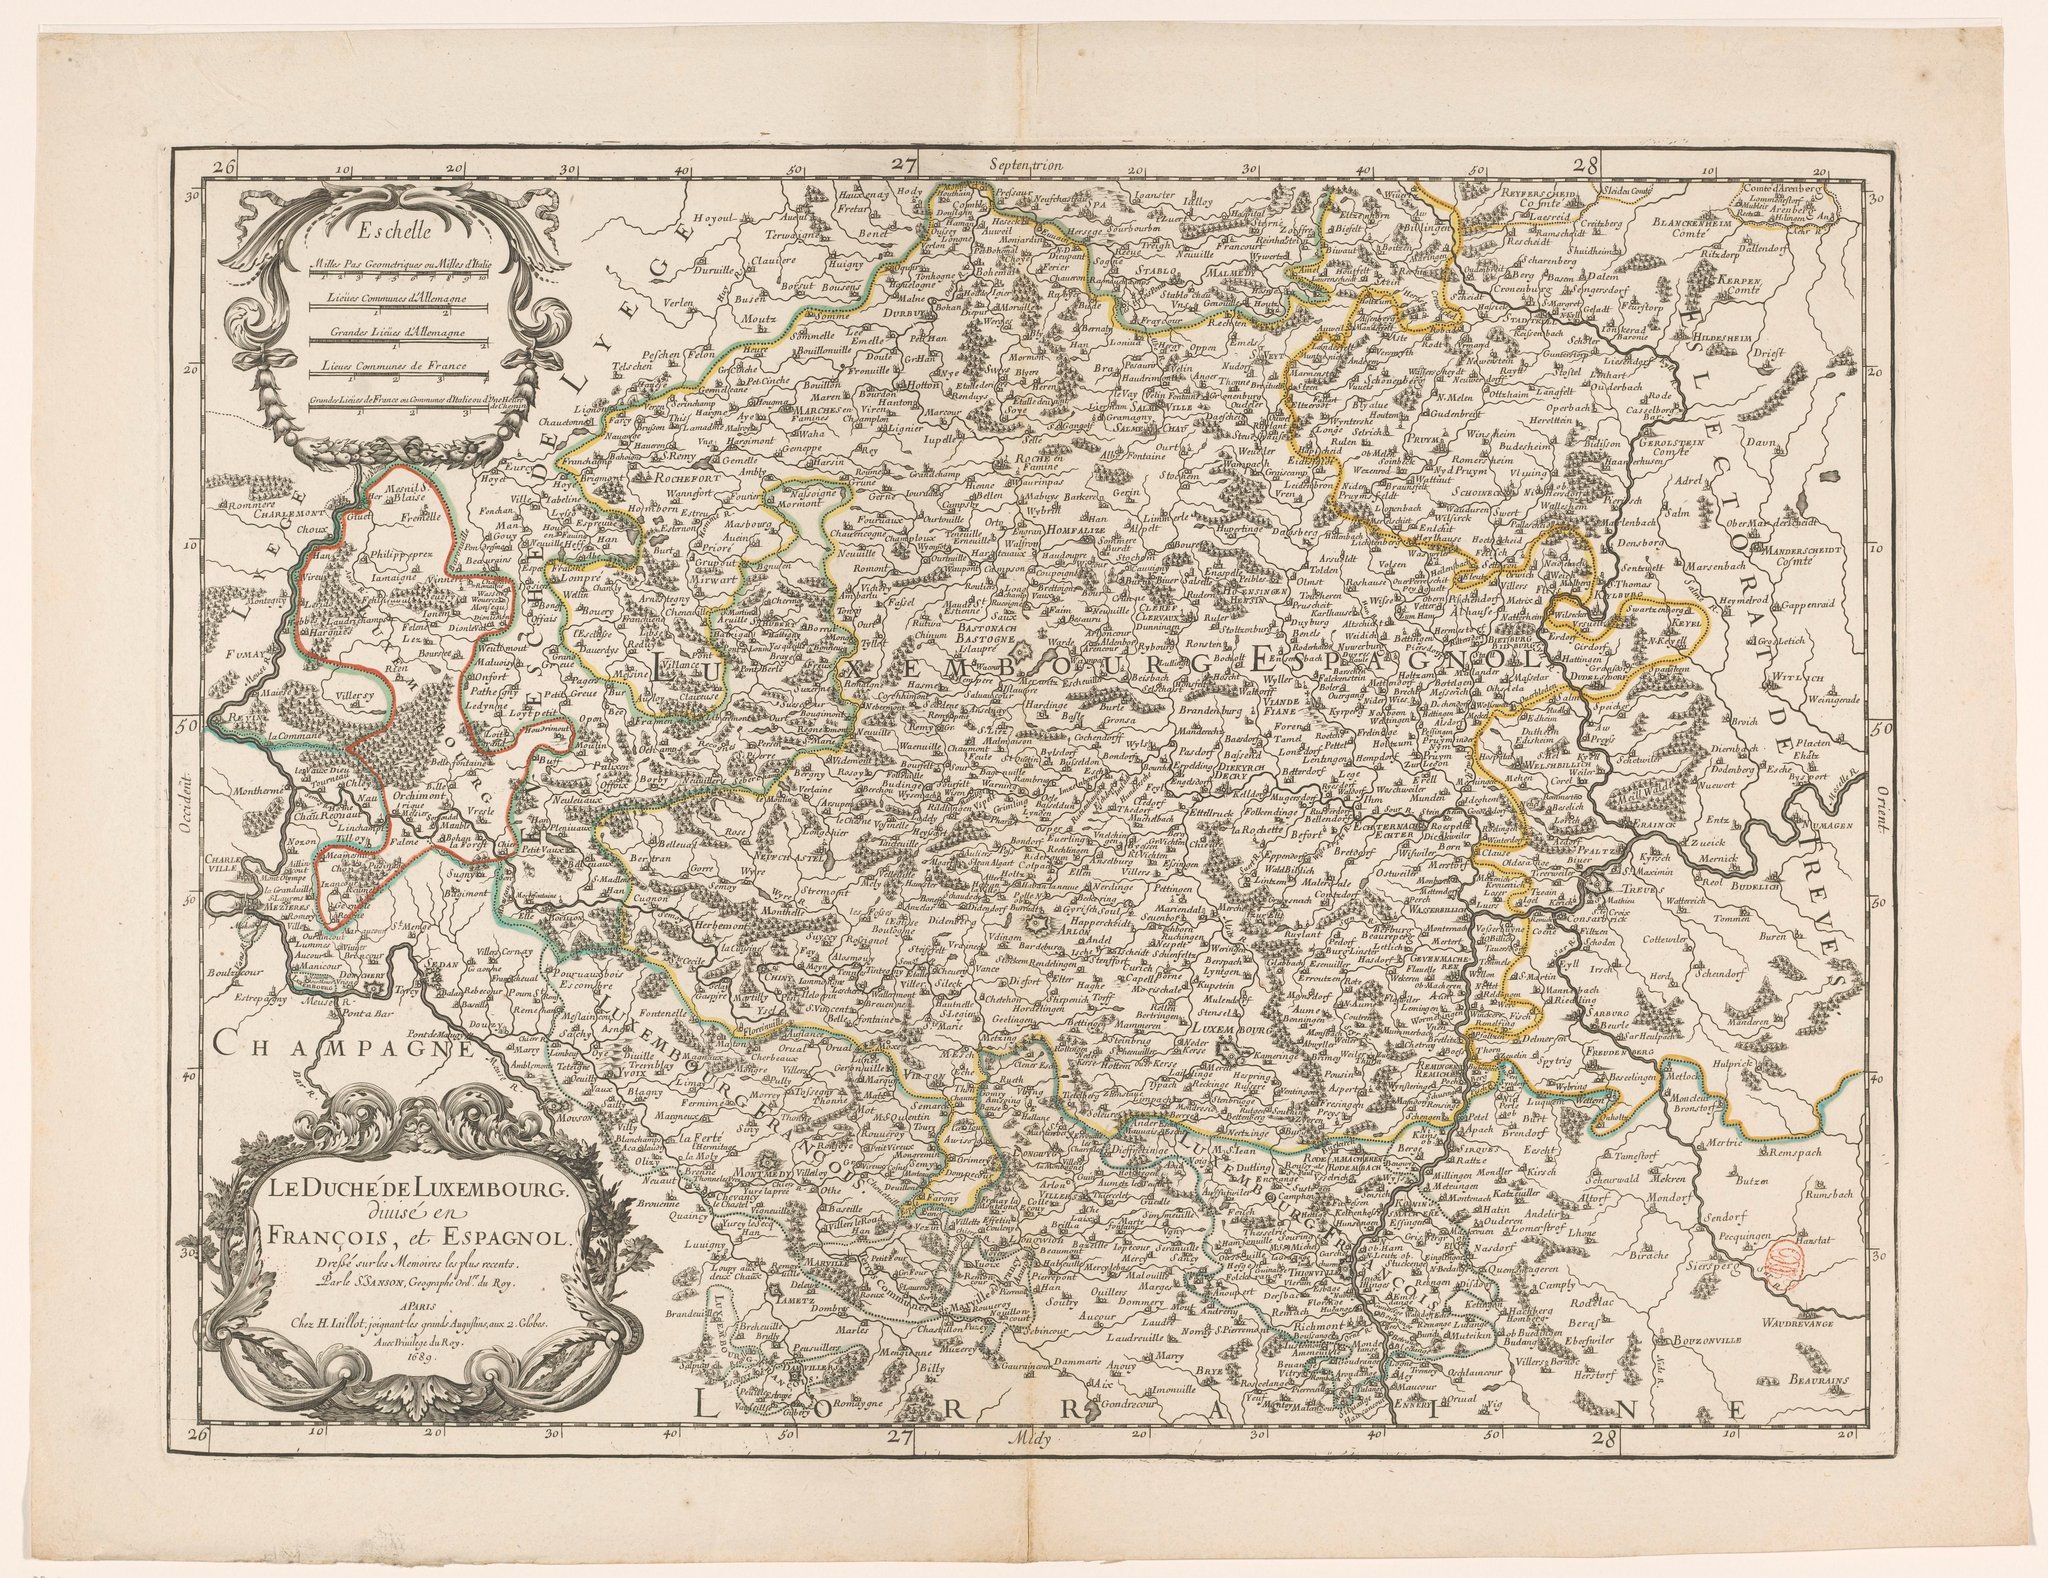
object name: print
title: Kaart van het hertogdom Luxemburg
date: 1689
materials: paper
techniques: engraving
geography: paris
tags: maps of separate countries or regions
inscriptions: collector's mark: Lugt 195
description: Kaart van het hertogdom Luxemburg. Linksonder de titelcartouche. Linksboven een cartouche met vijf schaalstokken: 10 Milles Pas Geometriques ou Milles d'Italie / 2 Lieües Communes d'Allemagne / 2 Grandes Lieuës d'Allemagne, en twee andere. De kaart is voorzien van een gradenverdeling langs de randen.